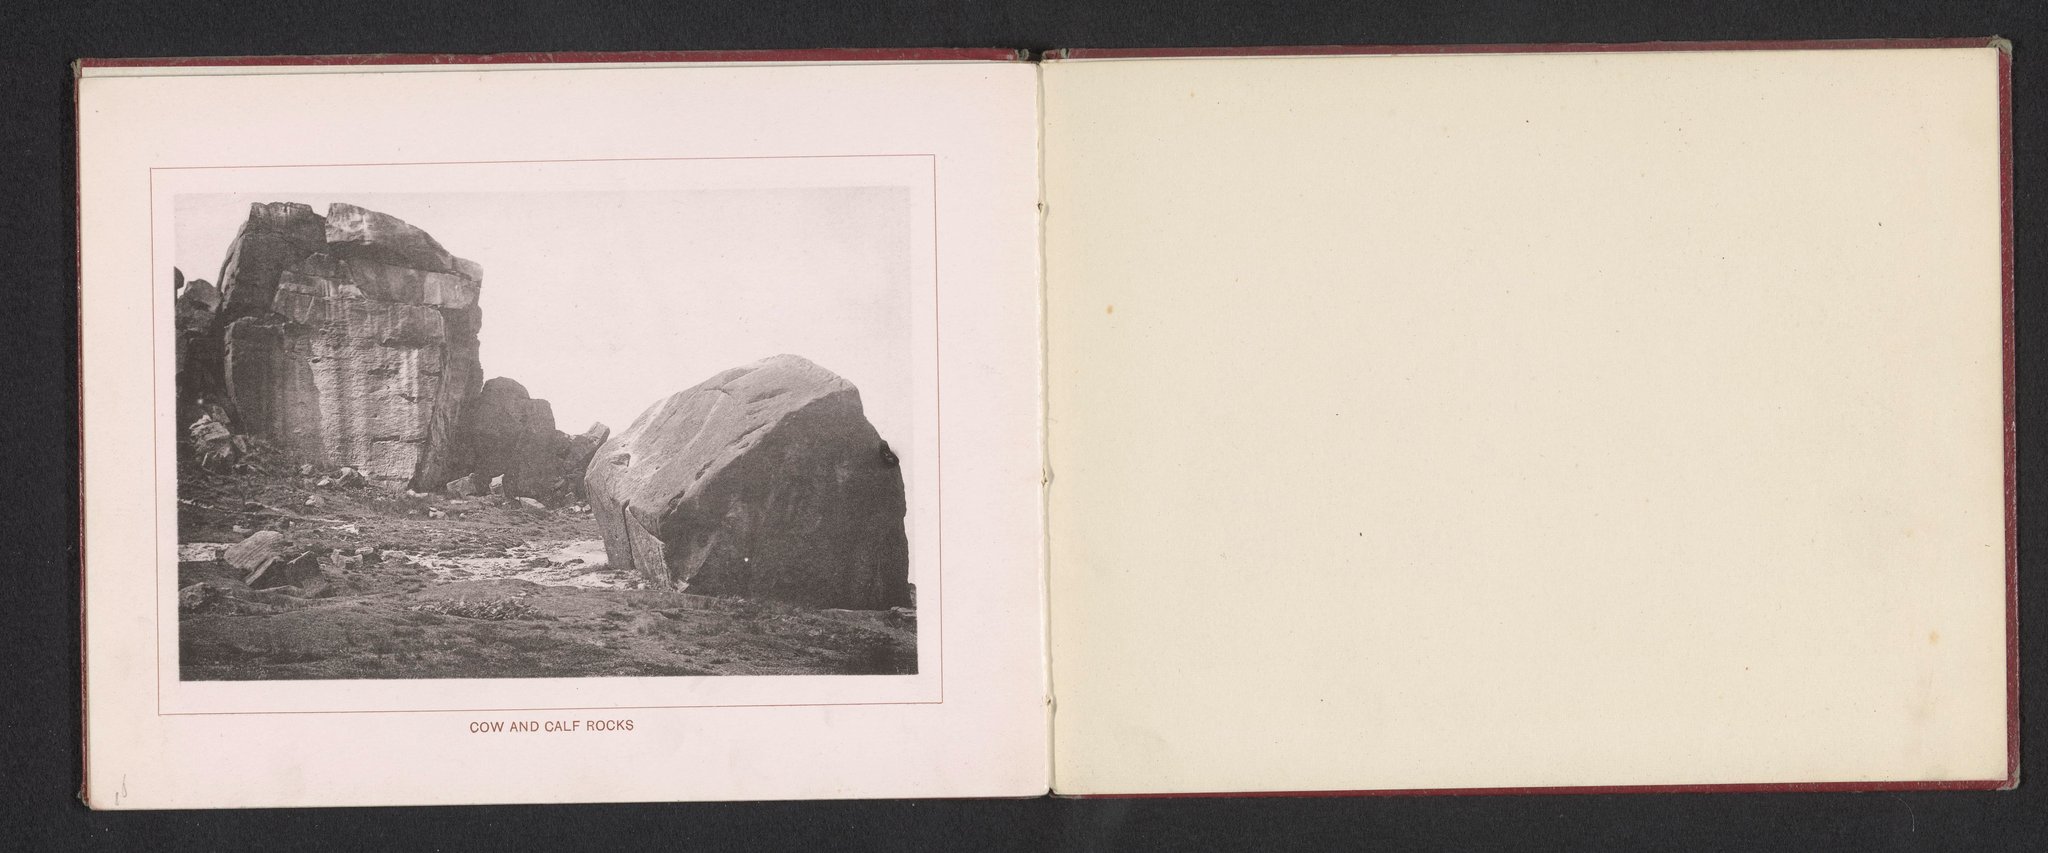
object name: page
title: Cow and calf rocks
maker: Anonymous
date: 1890-1900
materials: paper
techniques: photograph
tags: rock-formations